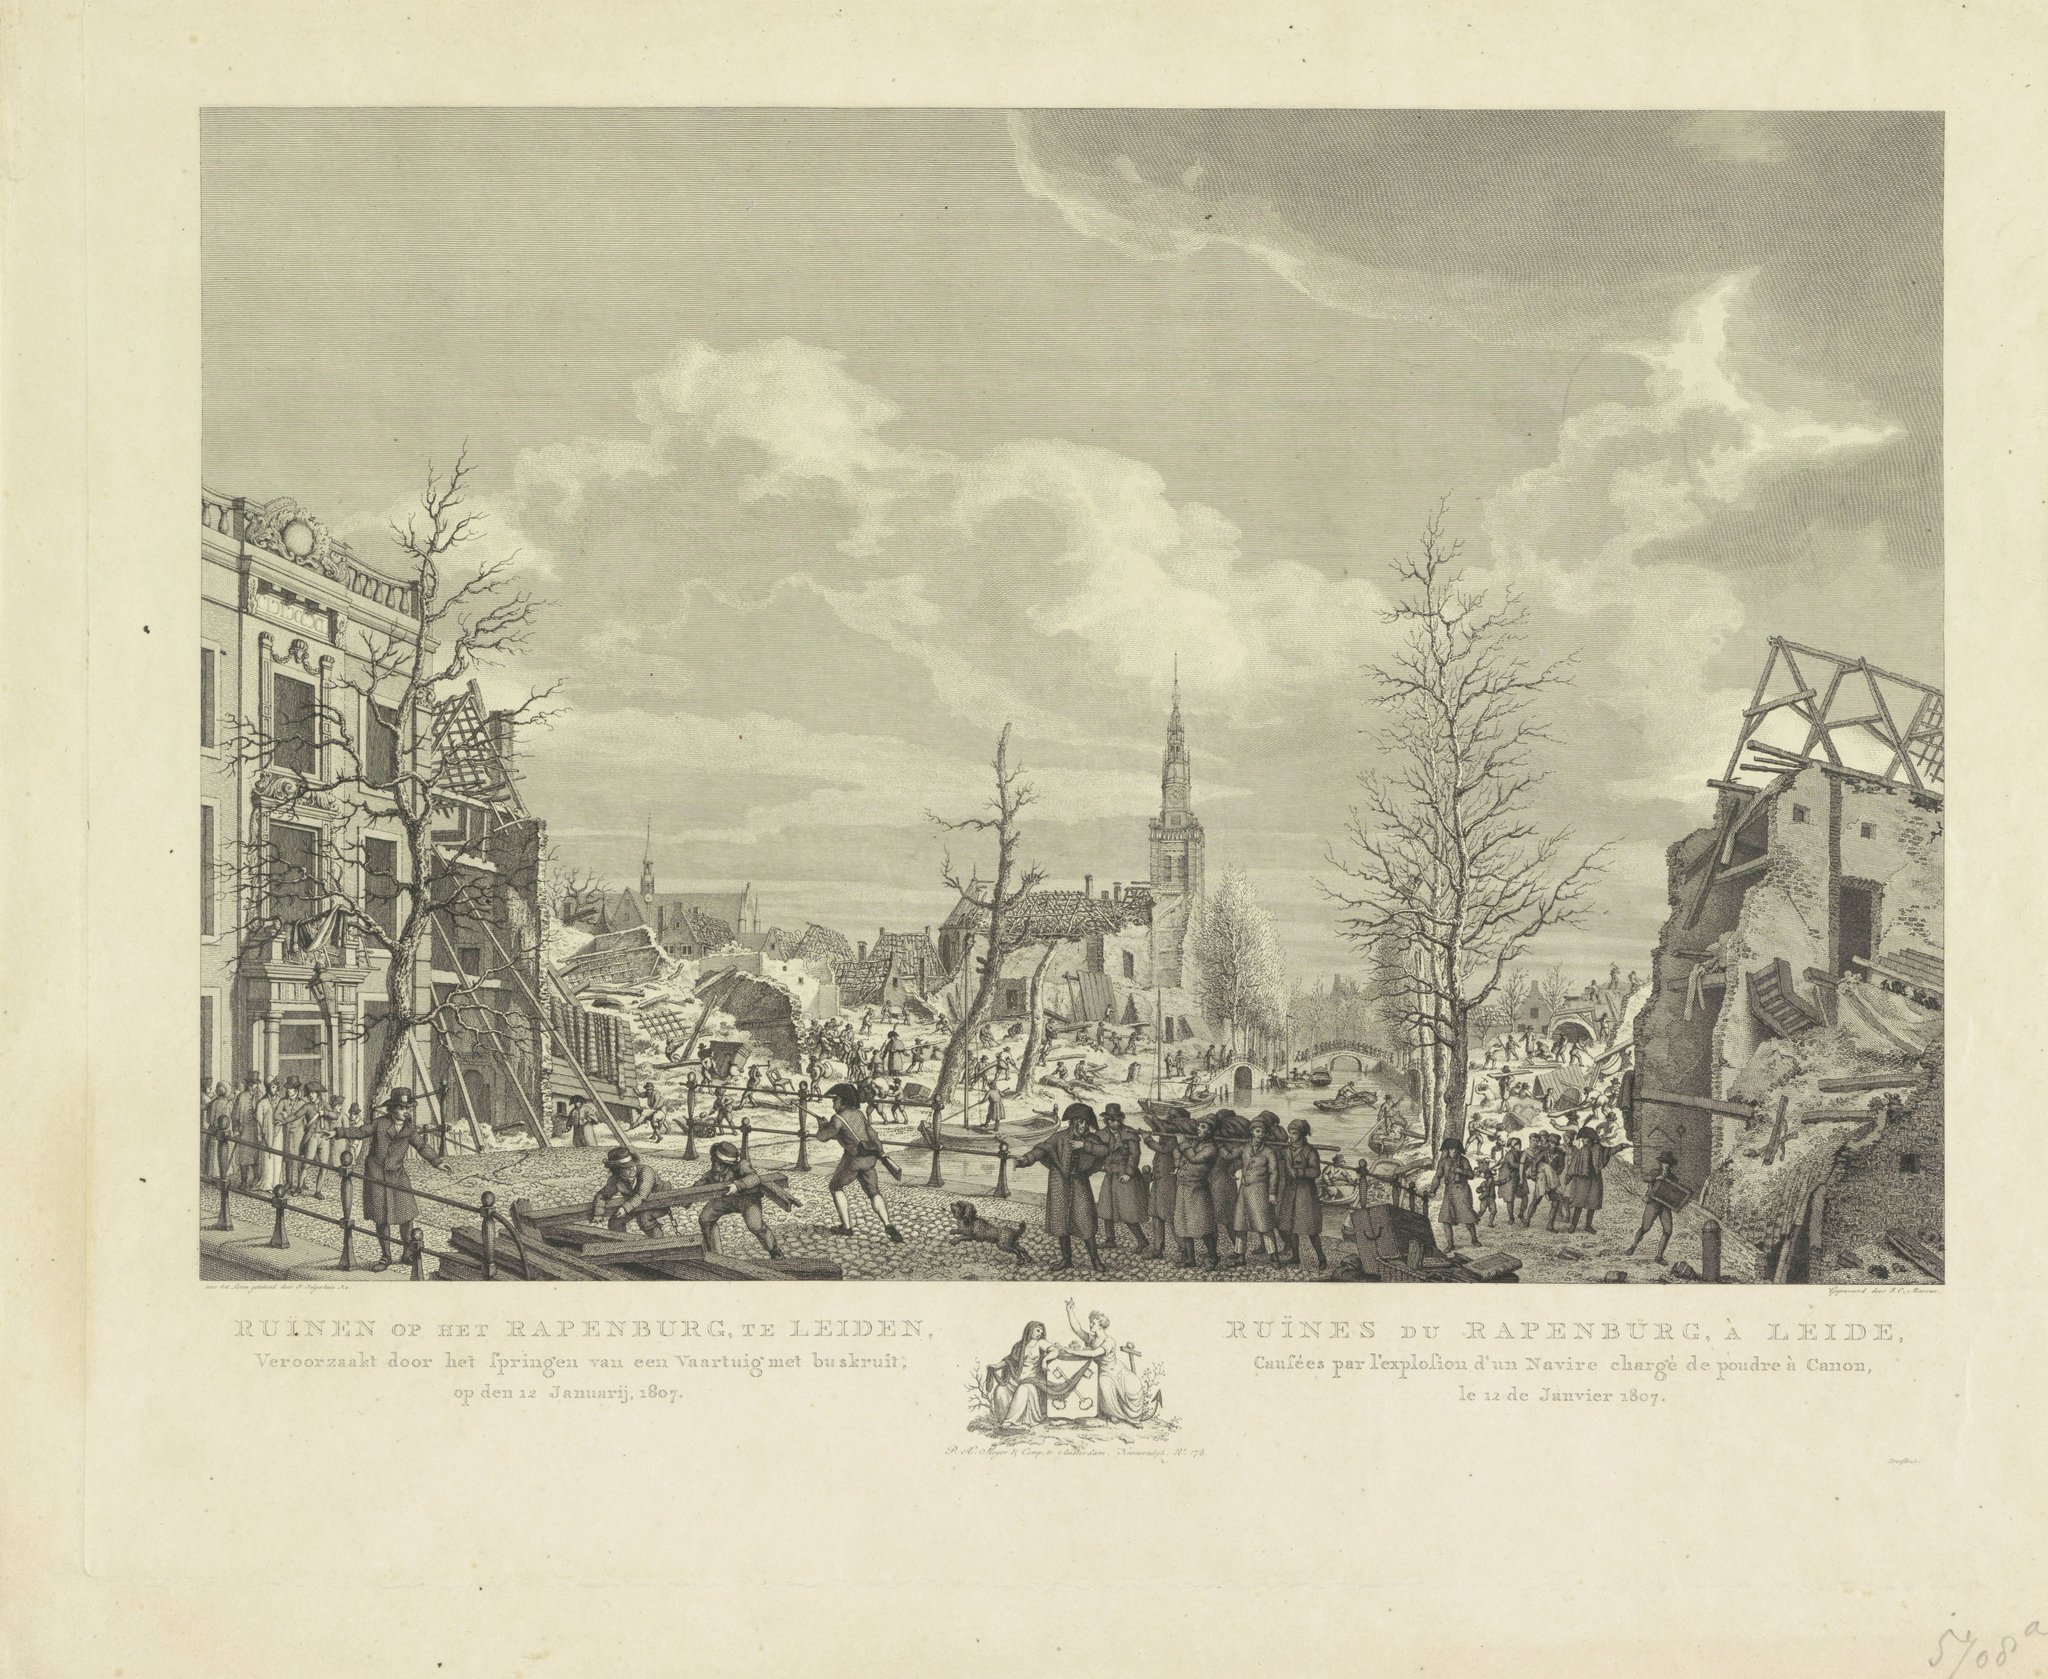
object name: print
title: Ruïnes op het Rapenburg te Leiden na de ramp, 1807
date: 1807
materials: paper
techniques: engraving, etching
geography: amsterdam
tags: death caused by undesired effects of human activities, in traffic, at work, etc., gunpowder disaster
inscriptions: collector's mark: Lugt 2228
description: Gezicht vanaf de Nieuwsteegbrug op het verwoest gebied na de buskruitramp op het Steenschuur, een gracht in het verlengde van het Rapenburg, te Leiden op 12 januari 1807. Opruimwerkzaamheden na de ramp, centraal de Saaihal, links in de verte de Pieterskerk. Op de voorgrond wordt het lichaam van een slachtoffer weggedragen. In de marge tussen de twee titels een vignet met de Leidse stadsmaagd getroost door de Hoop. Bij de prent behoort een gedrukte verklaring.